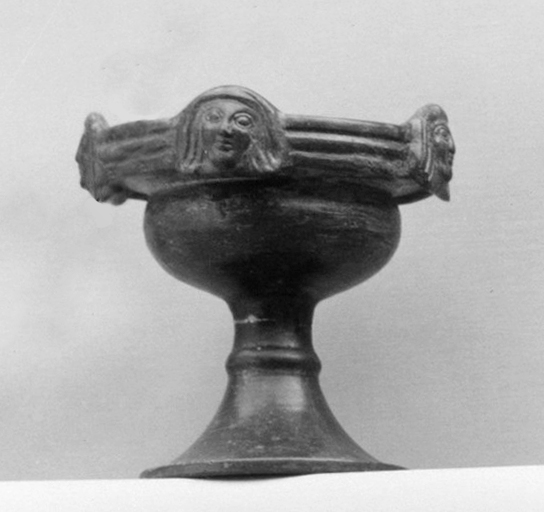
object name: cup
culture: etruscan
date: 550-501 BCE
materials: terracotta